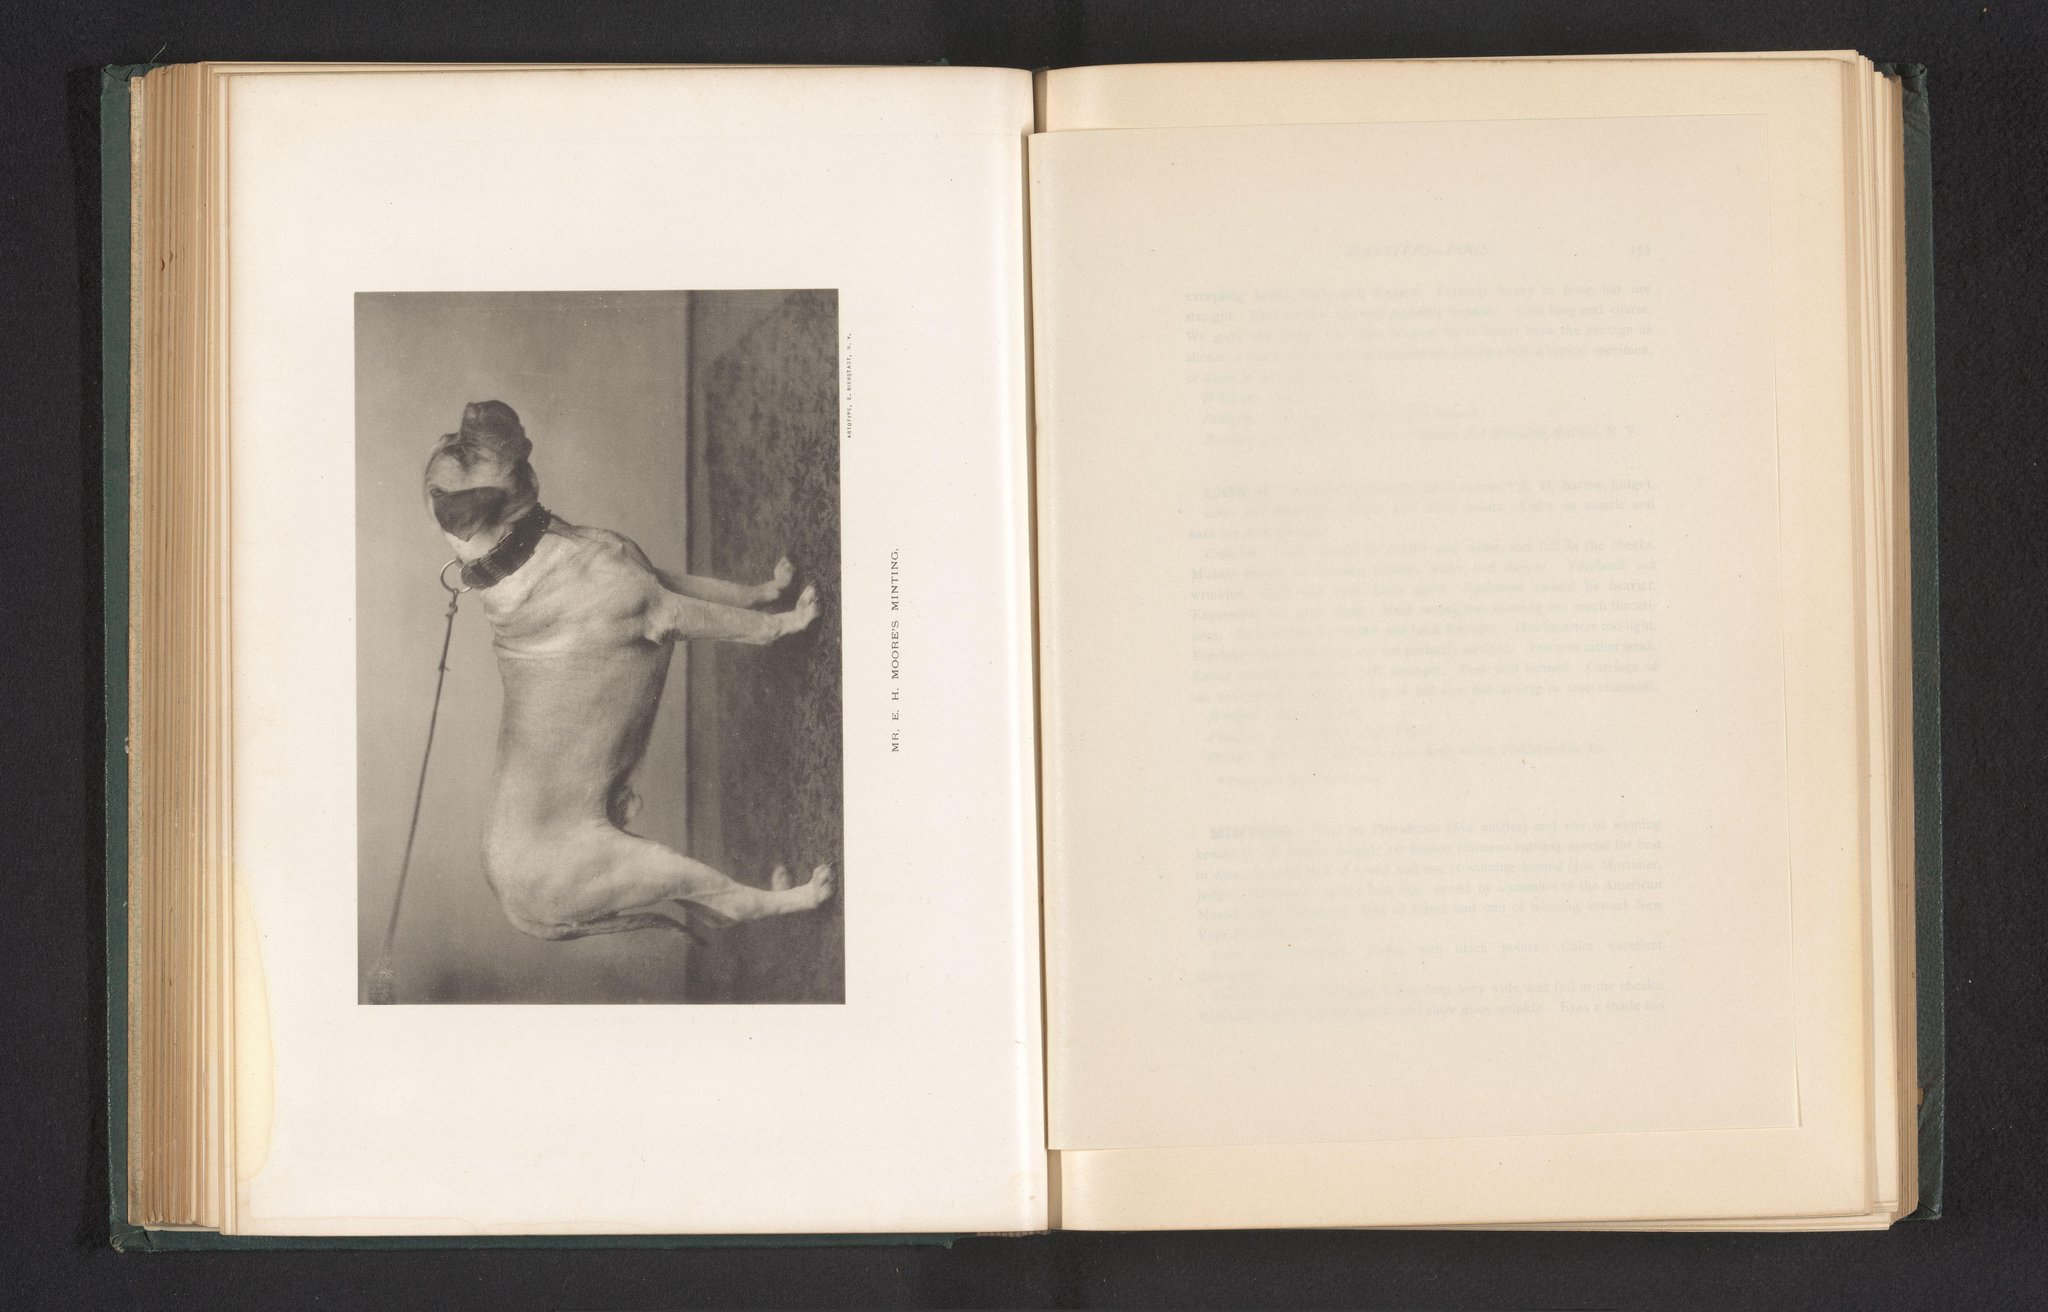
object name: page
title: Buldog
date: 1883-1888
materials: paper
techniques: photograph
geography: new york city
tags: dog (with name of kind)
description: Prent tegenover pagina 153, achter semi-transparante omslag.